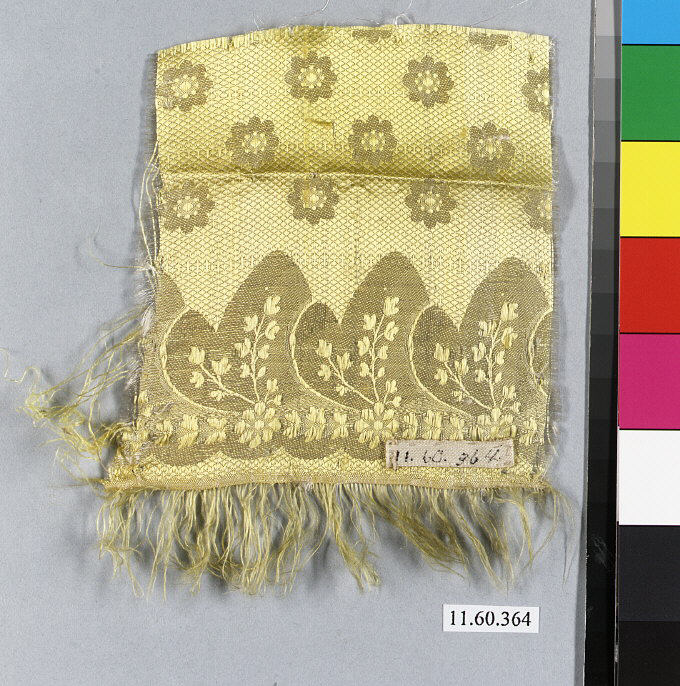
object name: fragment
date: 1801-1900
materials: silk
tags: flowers,leaves